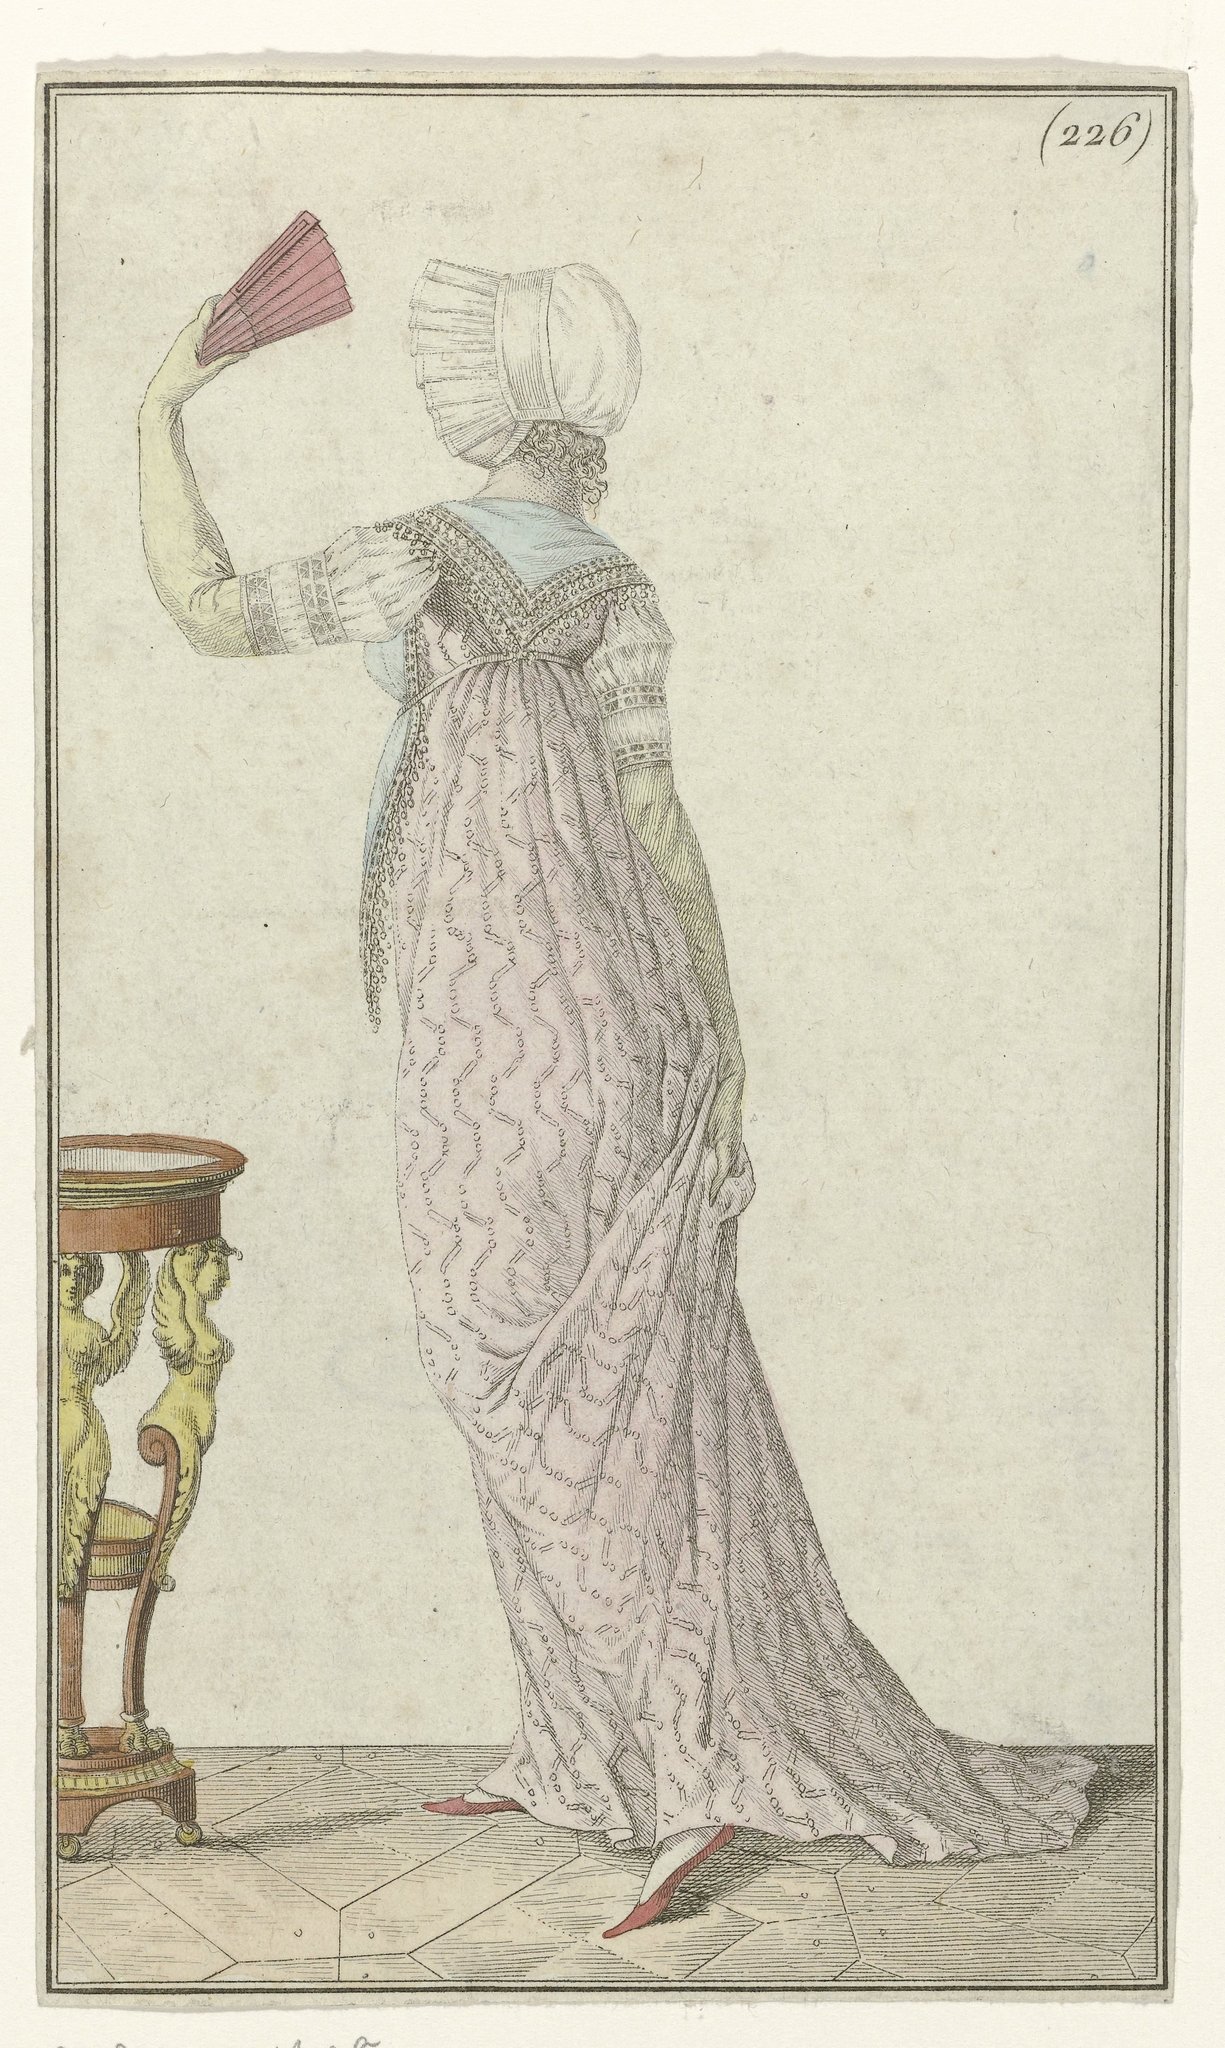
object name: fashion print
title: Journal des Dames et des Modes, Costume Parisien, 29 juin 1800, An 8 (226) : Cornette à la Paysan (...)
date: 1800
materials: paper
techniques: engraving, hand coloring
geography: paris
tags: head-gear (cornette) (+ women's clothes), fashion plates, shoes, sandals (+ women's clothes), gloves, mittens, etc. (+ women's clothes), dress, gown (+ women's clothes), table, fan (+ women's clothes), piece of clothing covering the breast or décolleté (fichu) (+ women's clothes)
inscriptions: caption: ‘Cornette à la Paysane Frange à grains de Muguet.’, title: ‘Costume Parisien.’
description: 'Cornette à la Paysane'. Fichu afgezet met franjes en kralen: 'grains de Muguet'. Japon met sleep en geometrisch zig-zag patroon. Vouwwaaier. De prent maakt deel uit van het modetijdschrift Journal des Dames et des Modes, uitgegeven door Pierre de la Mésangère, Parijs, 1797-1839.